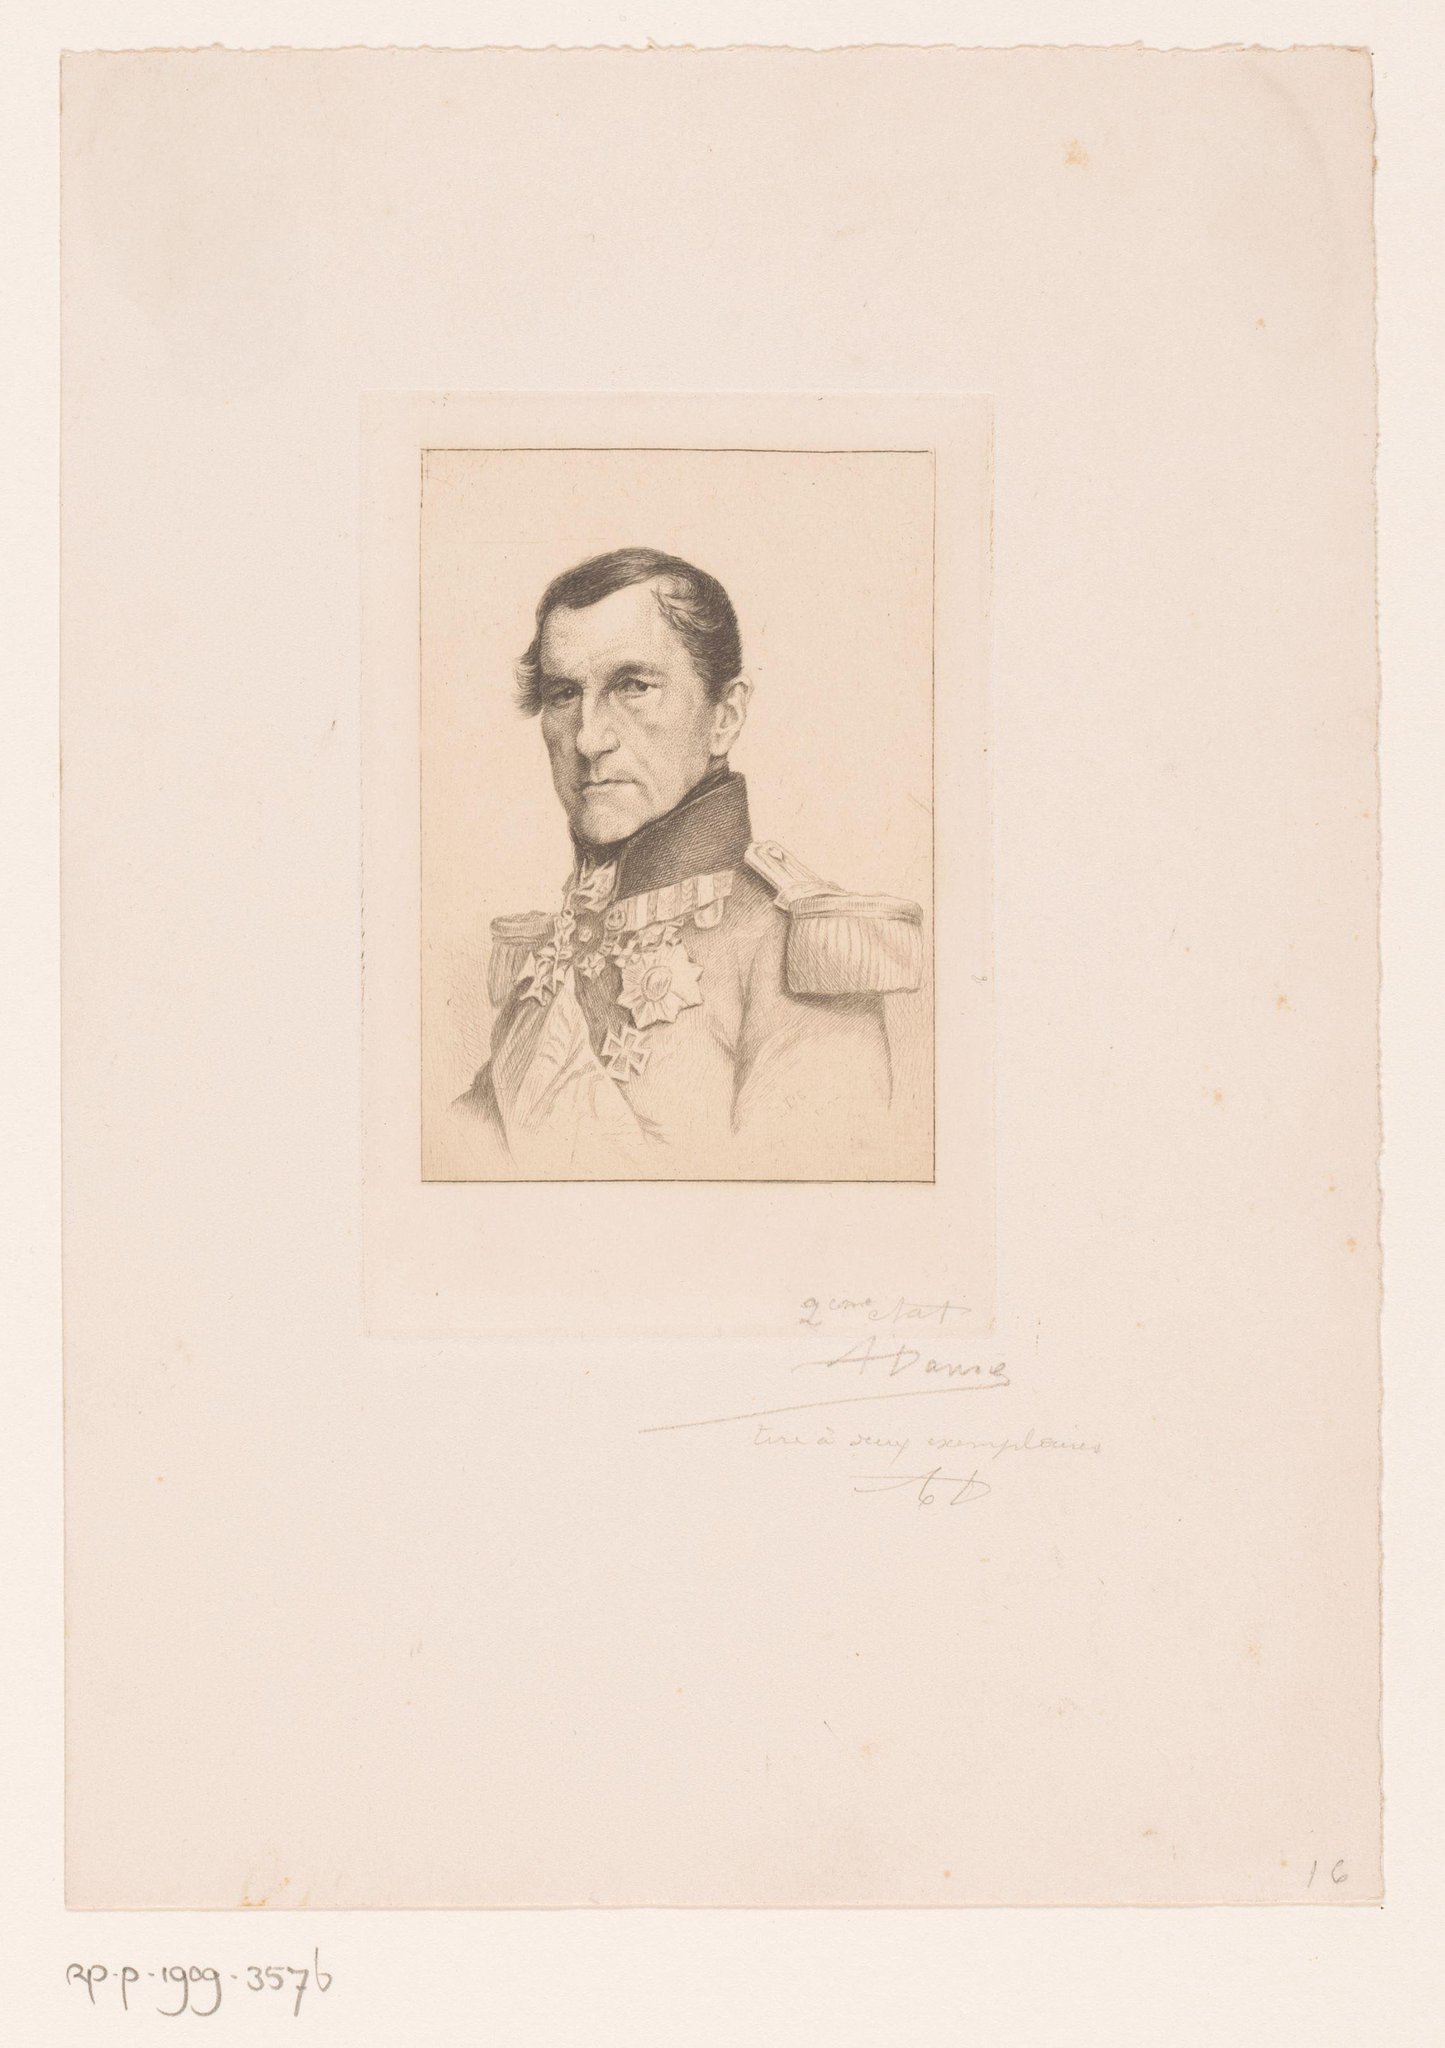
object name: print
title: Portret van Leopold I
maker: auguste danse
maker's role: print maker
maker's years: 1829-1929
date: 1883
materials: paper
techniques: etching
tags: laeken, leopold i (koning der belgen), historical persons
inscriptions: annotation: ‘2me état; tire à deux exemplaires’, collector's mark: Lugt 2228